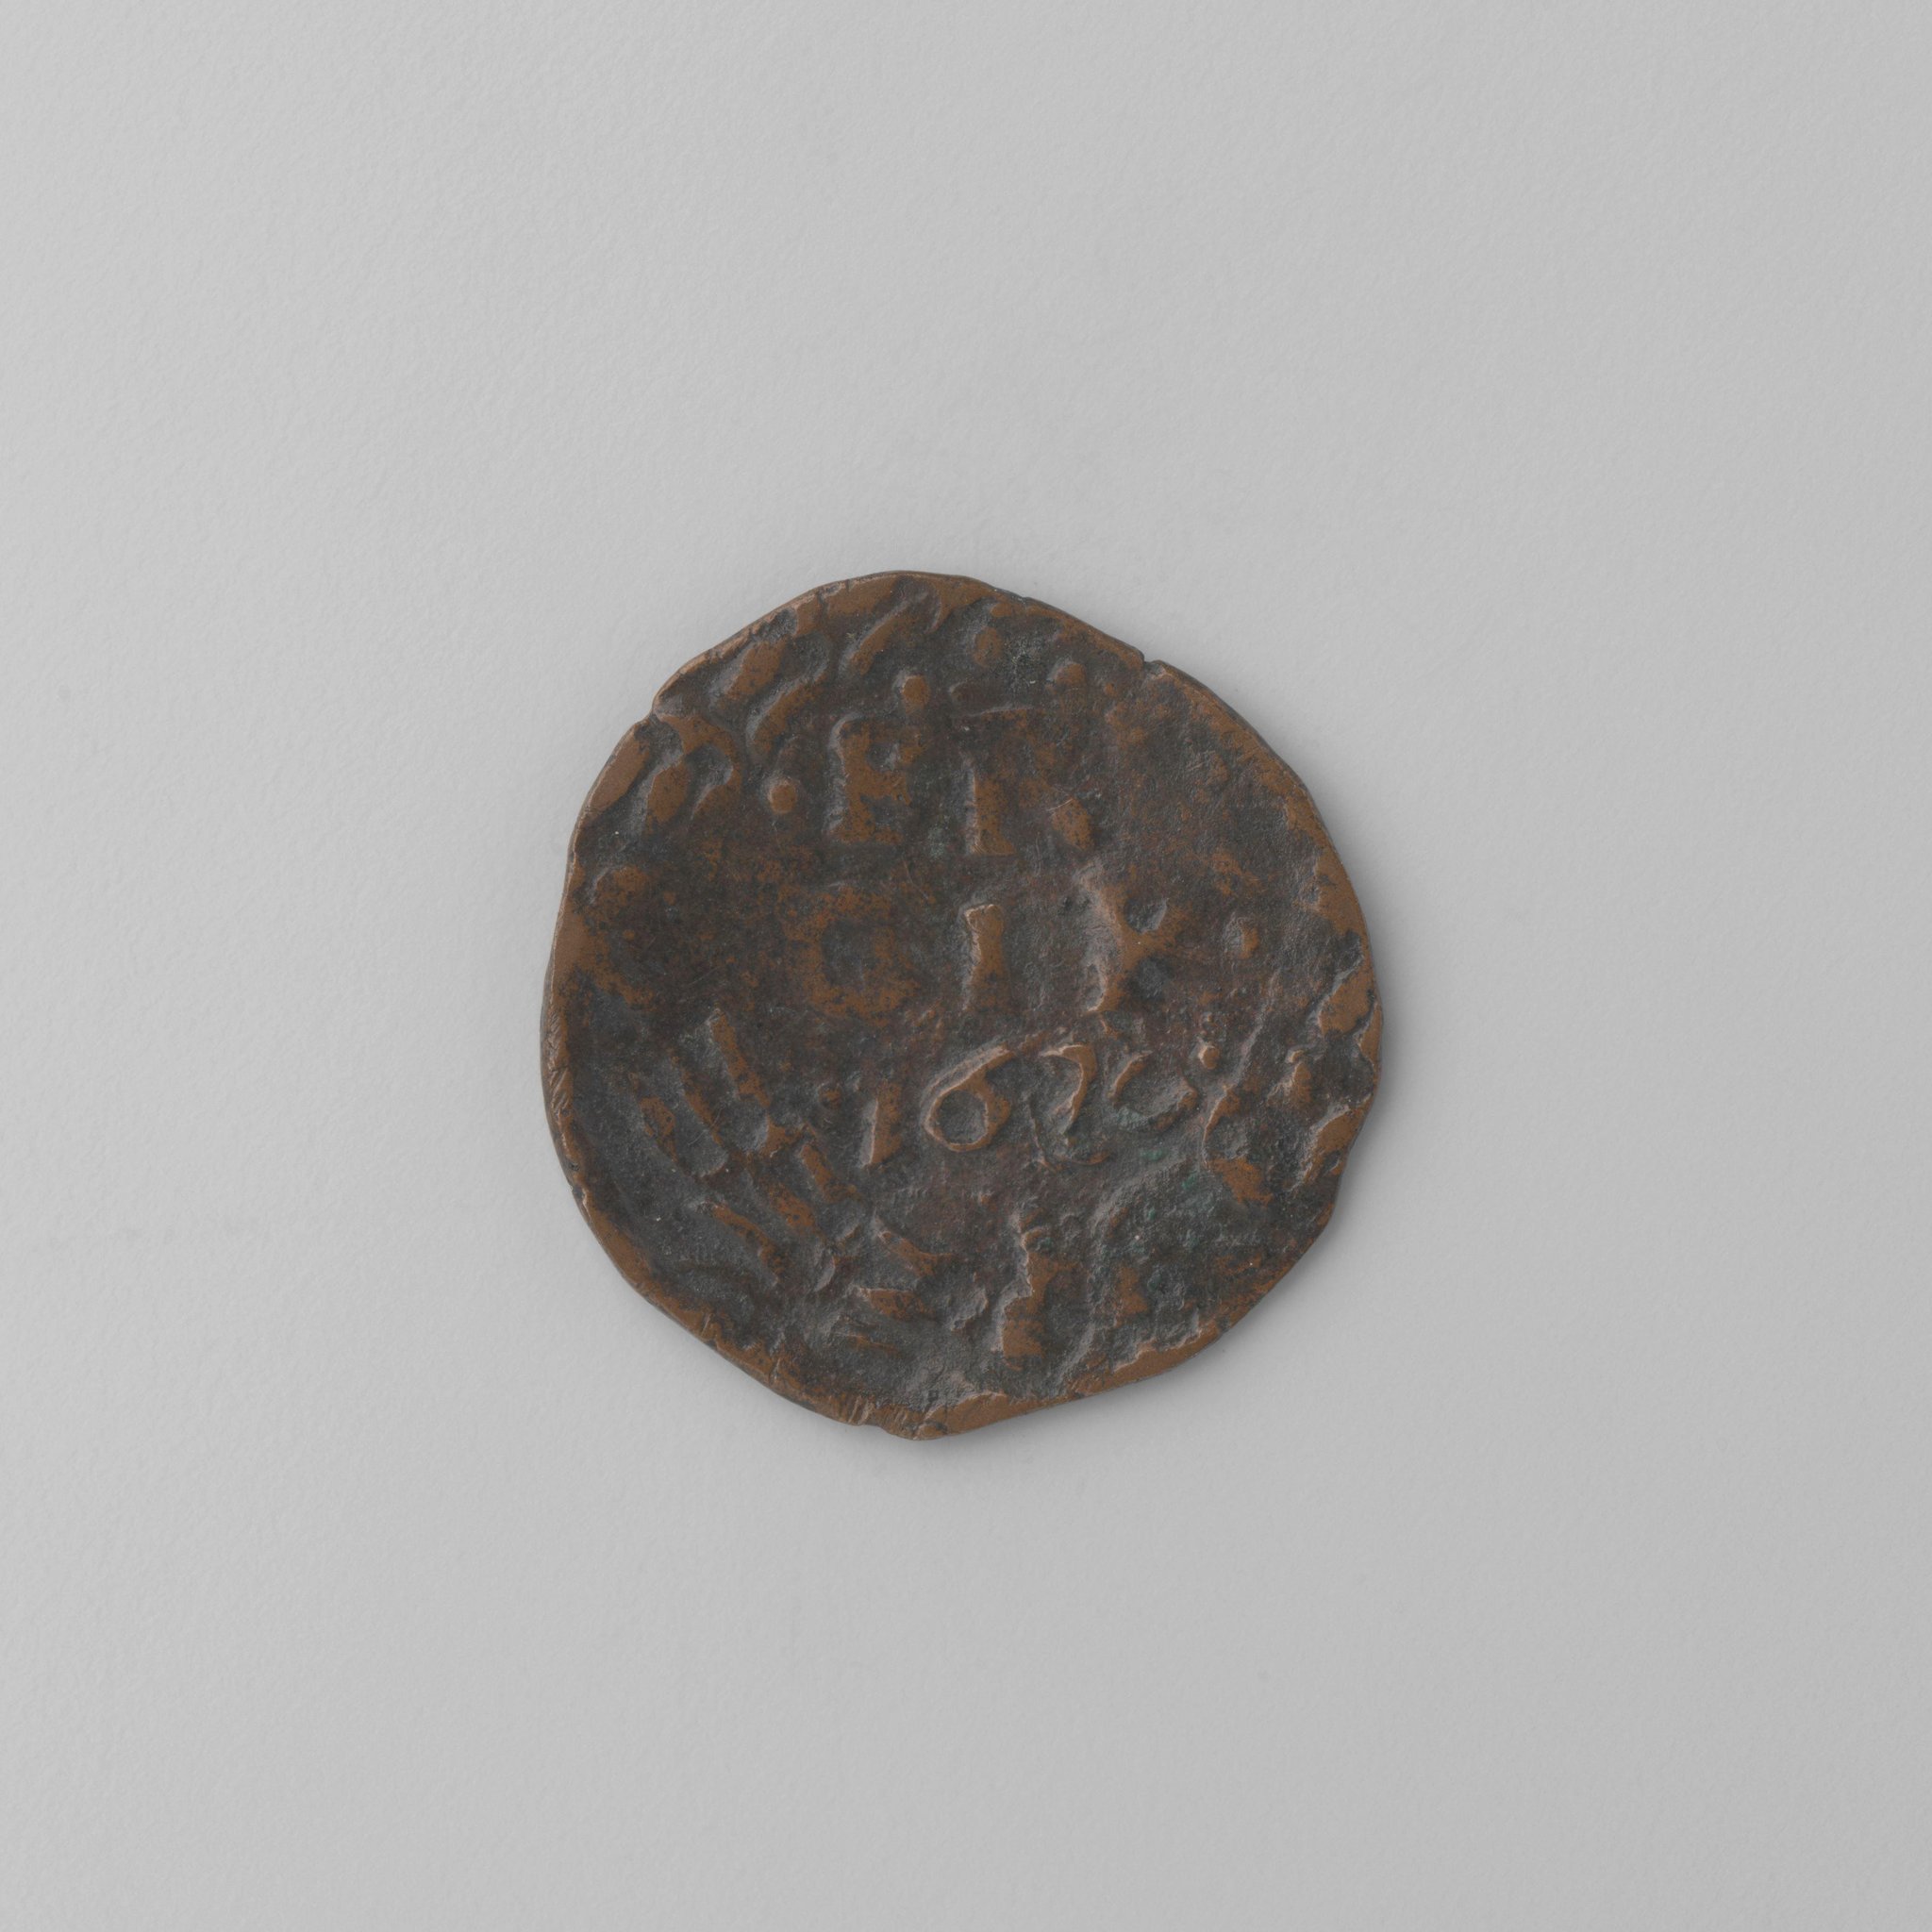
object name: coin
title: Reckheimse duit van Ferdinand van Aspremont-Lynden (1636-1665), 1620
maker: heer van reckheim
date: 1620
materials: copper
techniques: striking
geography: rekem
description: Koperen munt. Voorzijde: versierd wapenschild van Friesland, onder het schild vijf rondjes. Keerzijde: binnen een krans twee-regelig opschrift, waaronder jaartal.